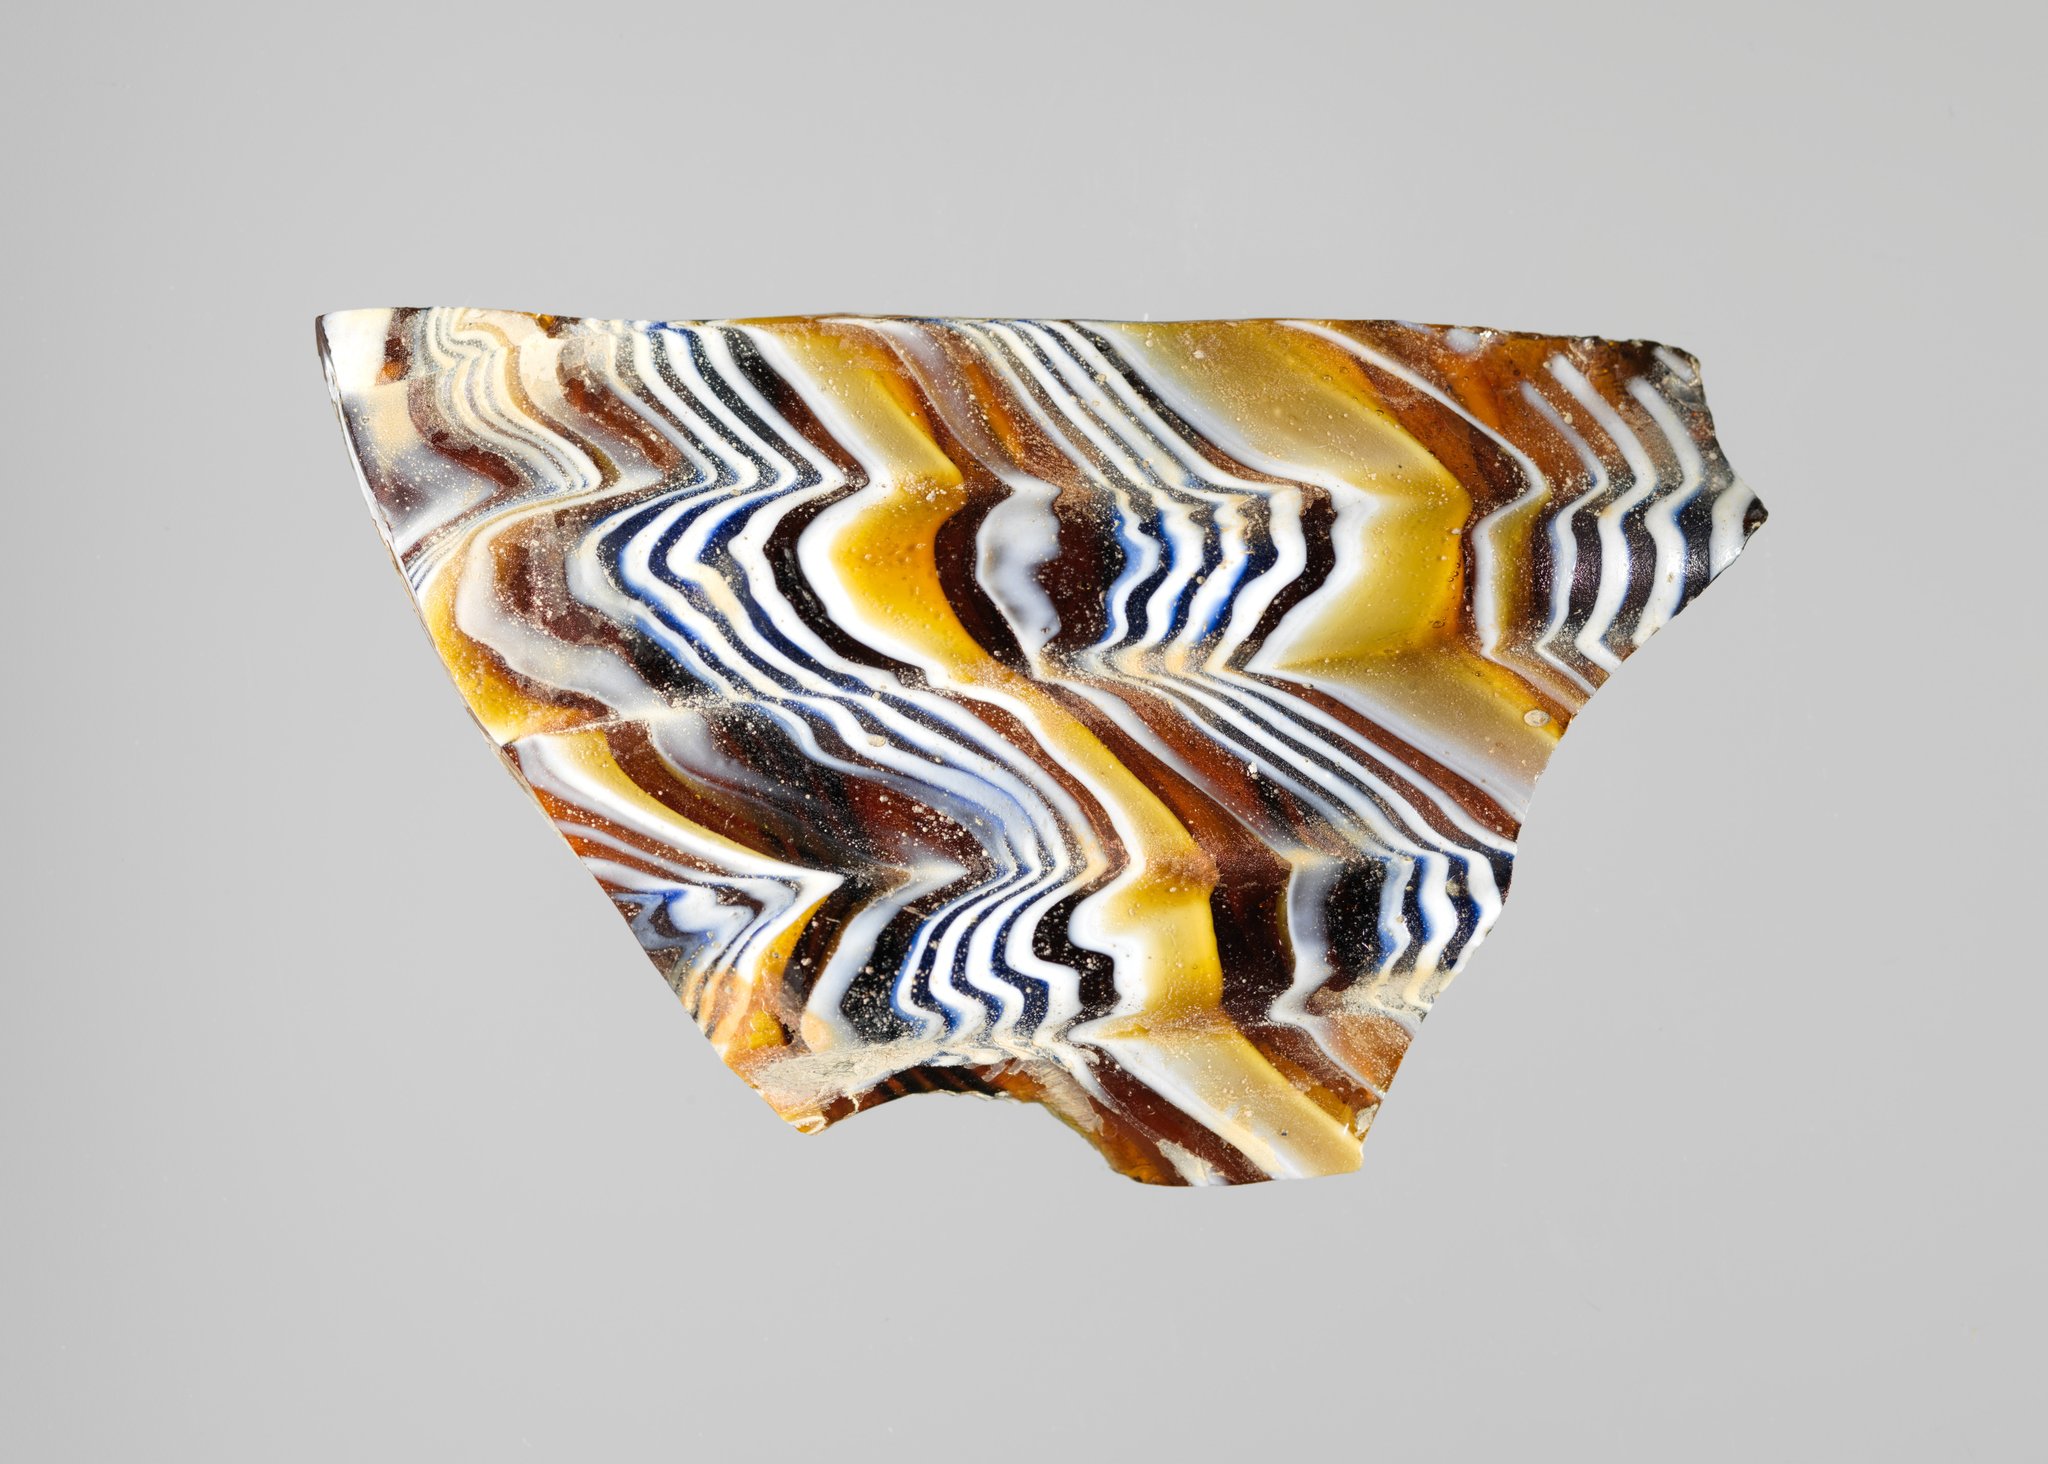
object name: fragment, mosaic bowl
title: Glass mosaic ribbed bowl fragment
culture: roman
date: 34 BCE-33 CE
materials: glass